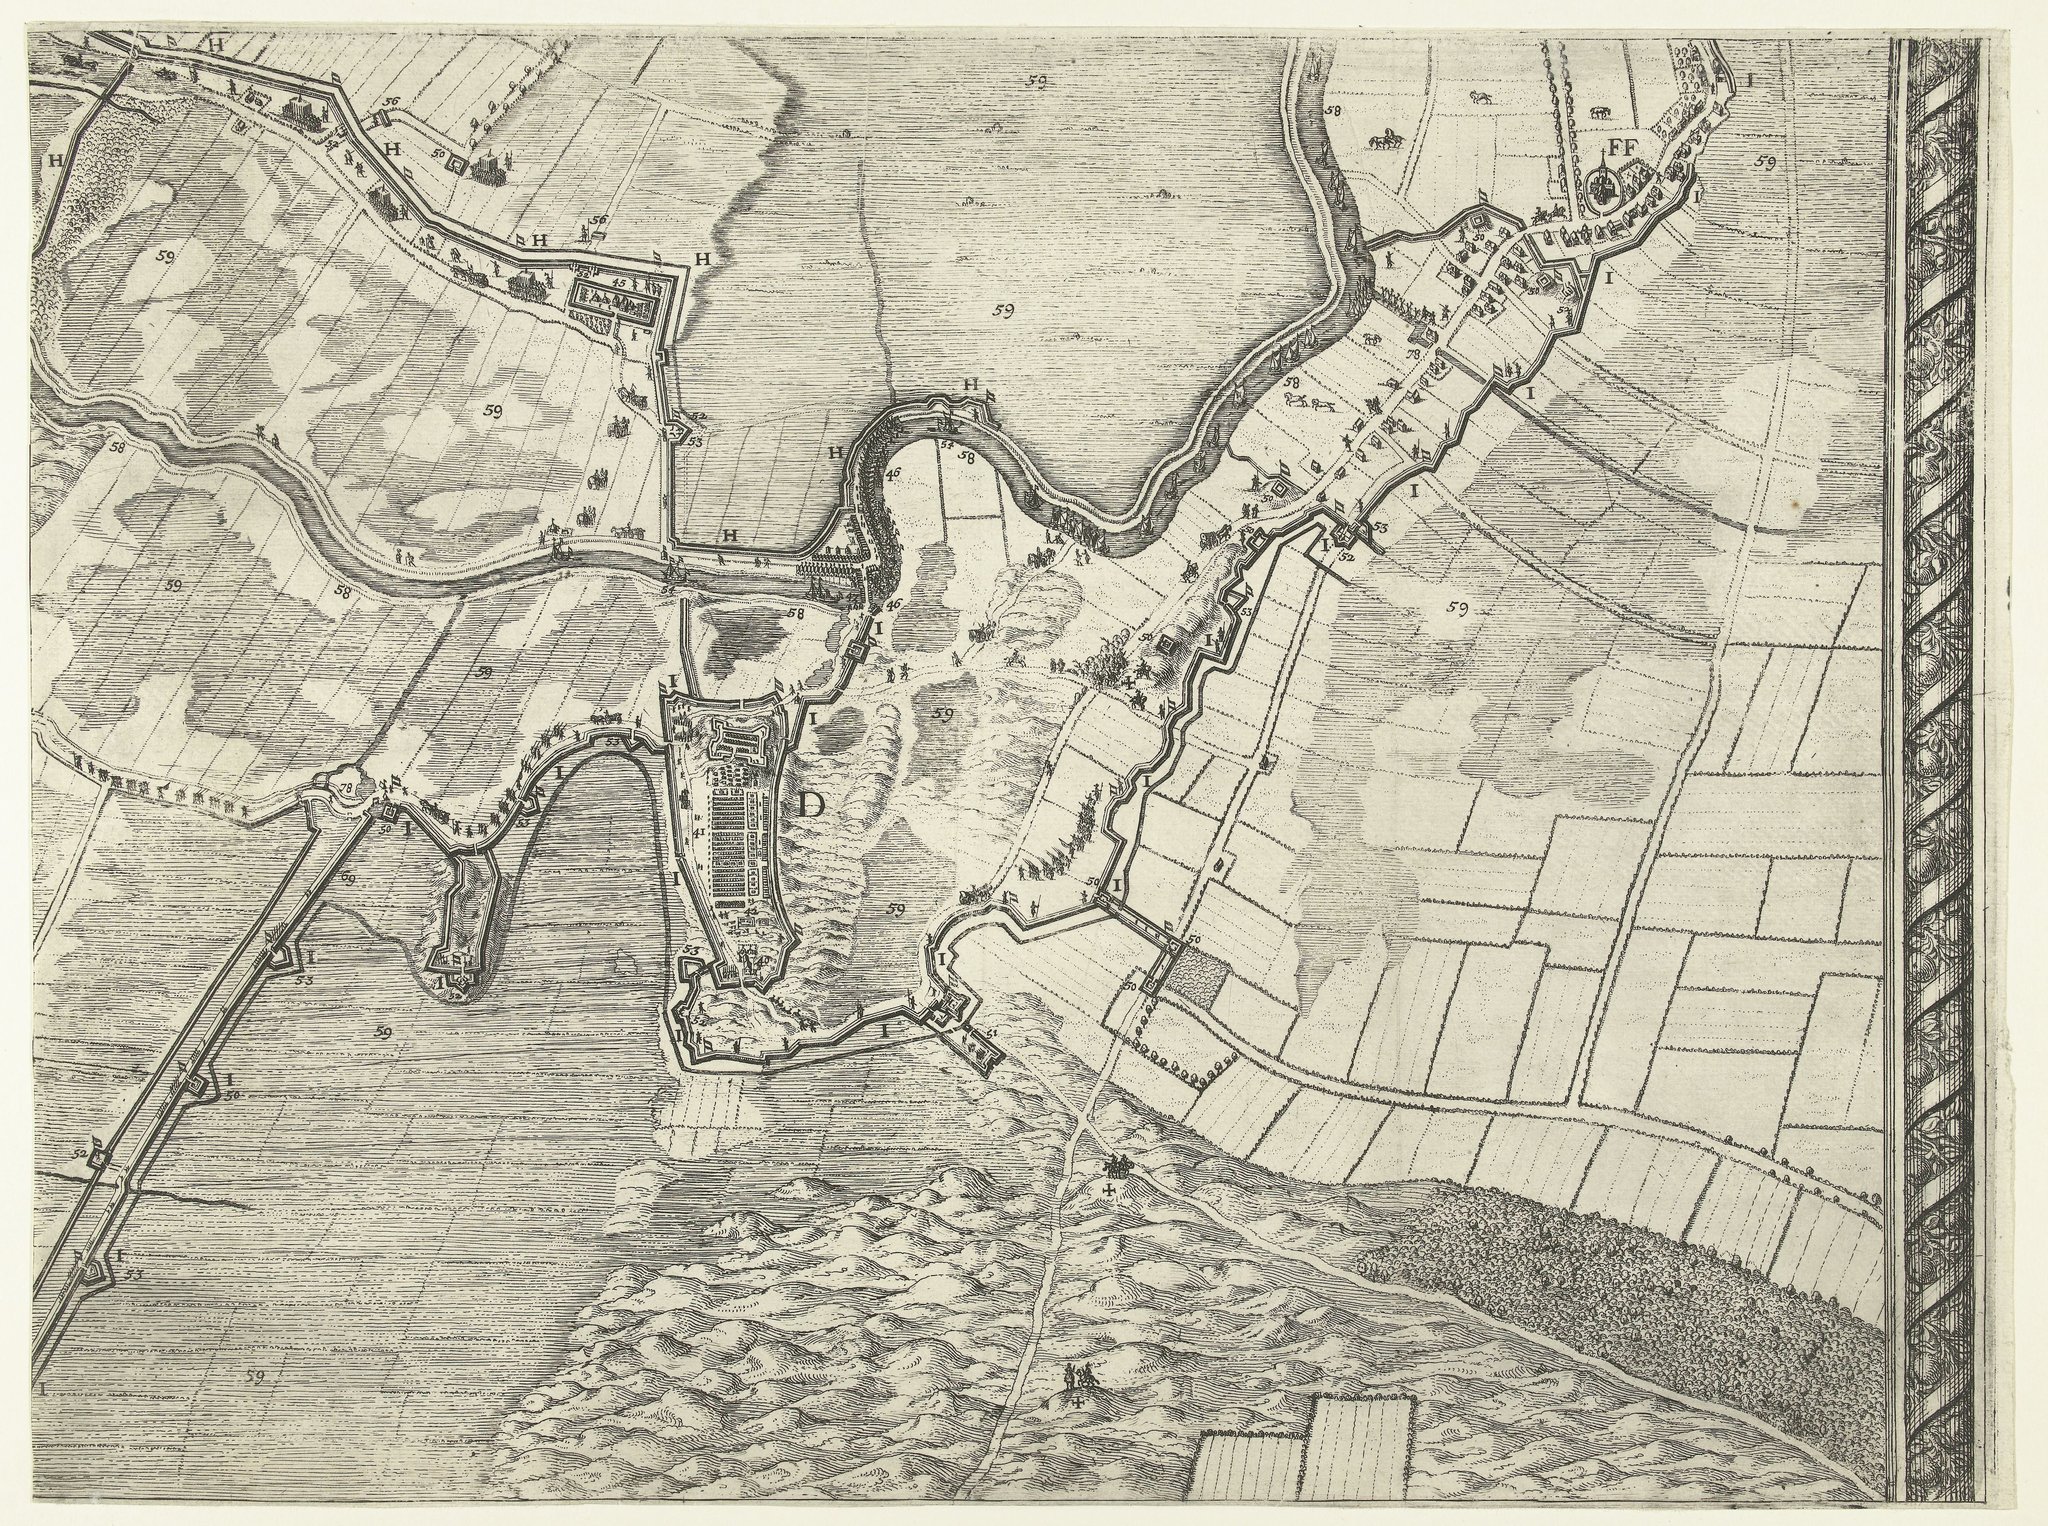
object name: map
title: Expugnatio Fortissimae Urbis Bredae Ao.-1637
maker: balthasar florisz. van berckenrode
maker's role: draughtsman, print maker, publisher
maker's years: 1591-1645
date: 1637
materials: paper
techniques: etching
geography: northern netherlands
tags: delft, the hague, frederick henry (prince of orange), maps of separate countries or regions, siege, position war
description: De belegering en verovering van Breda door het Staatse leger onder Frederik Hendrik, 23 juli - 10 oktober 1637. Onderdeel van een ongemonteerde ensemble bestaande uit 9 bladen (en 2 hier ontbrekende tekstbladen). Blad middenrechts met een deel van de kaart met een legerkamp van de belegeraars.